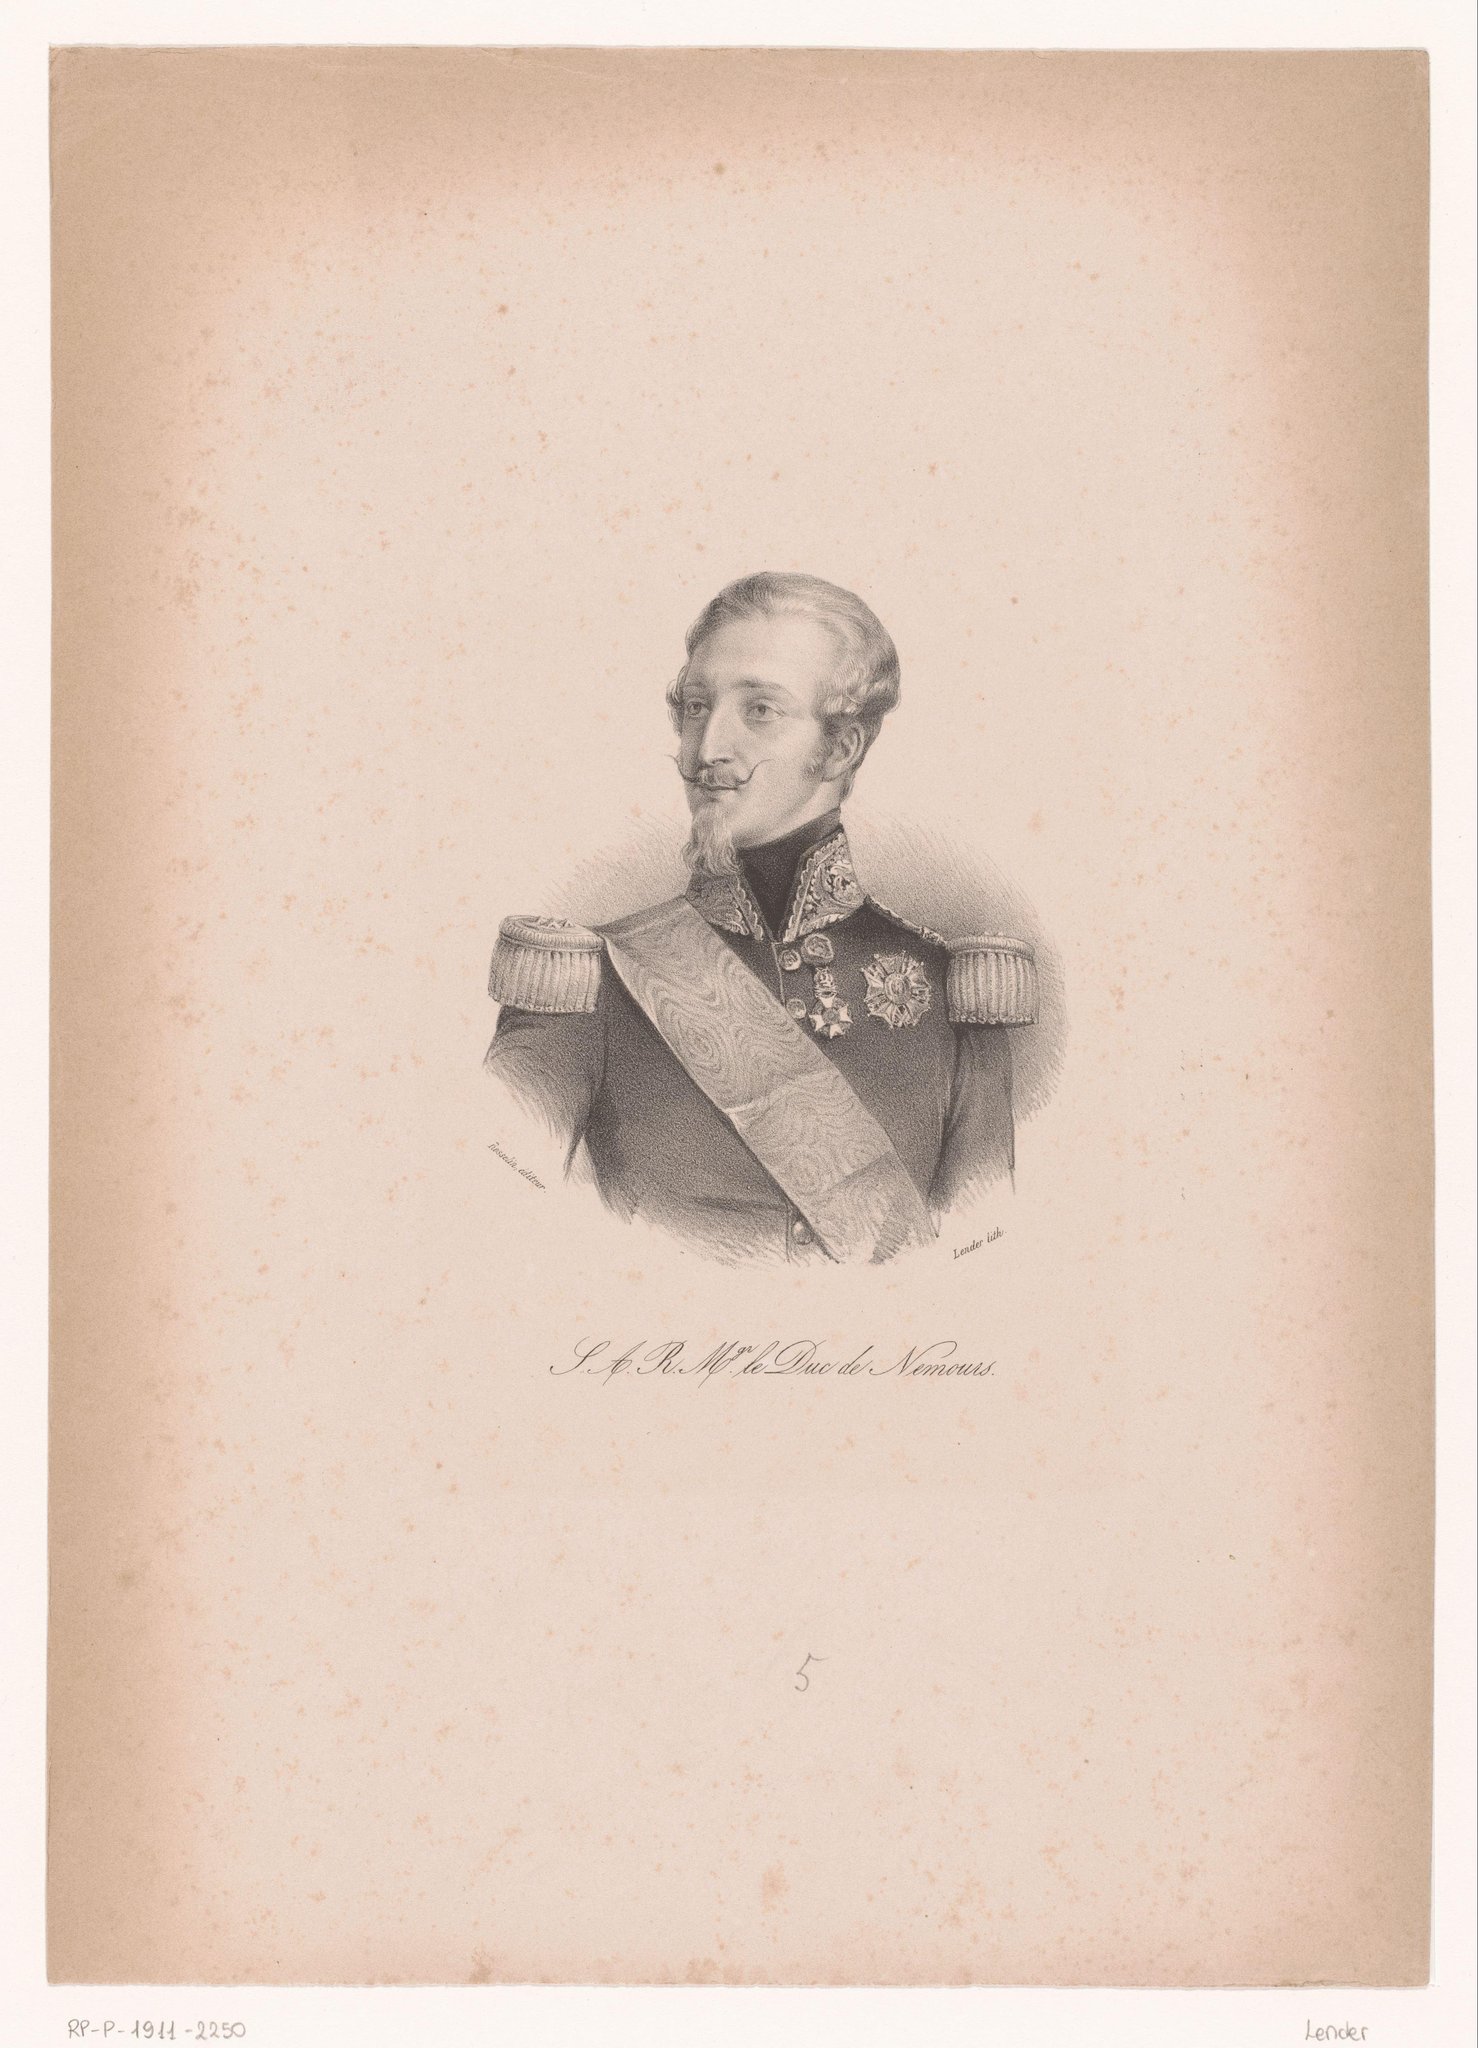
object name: print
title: S.A.R. M.gr le Duc de Nemours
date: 1835-1860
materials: paper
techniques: lithograph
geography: paris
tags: historical persons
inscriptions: collector's mark: Lugt 2228a